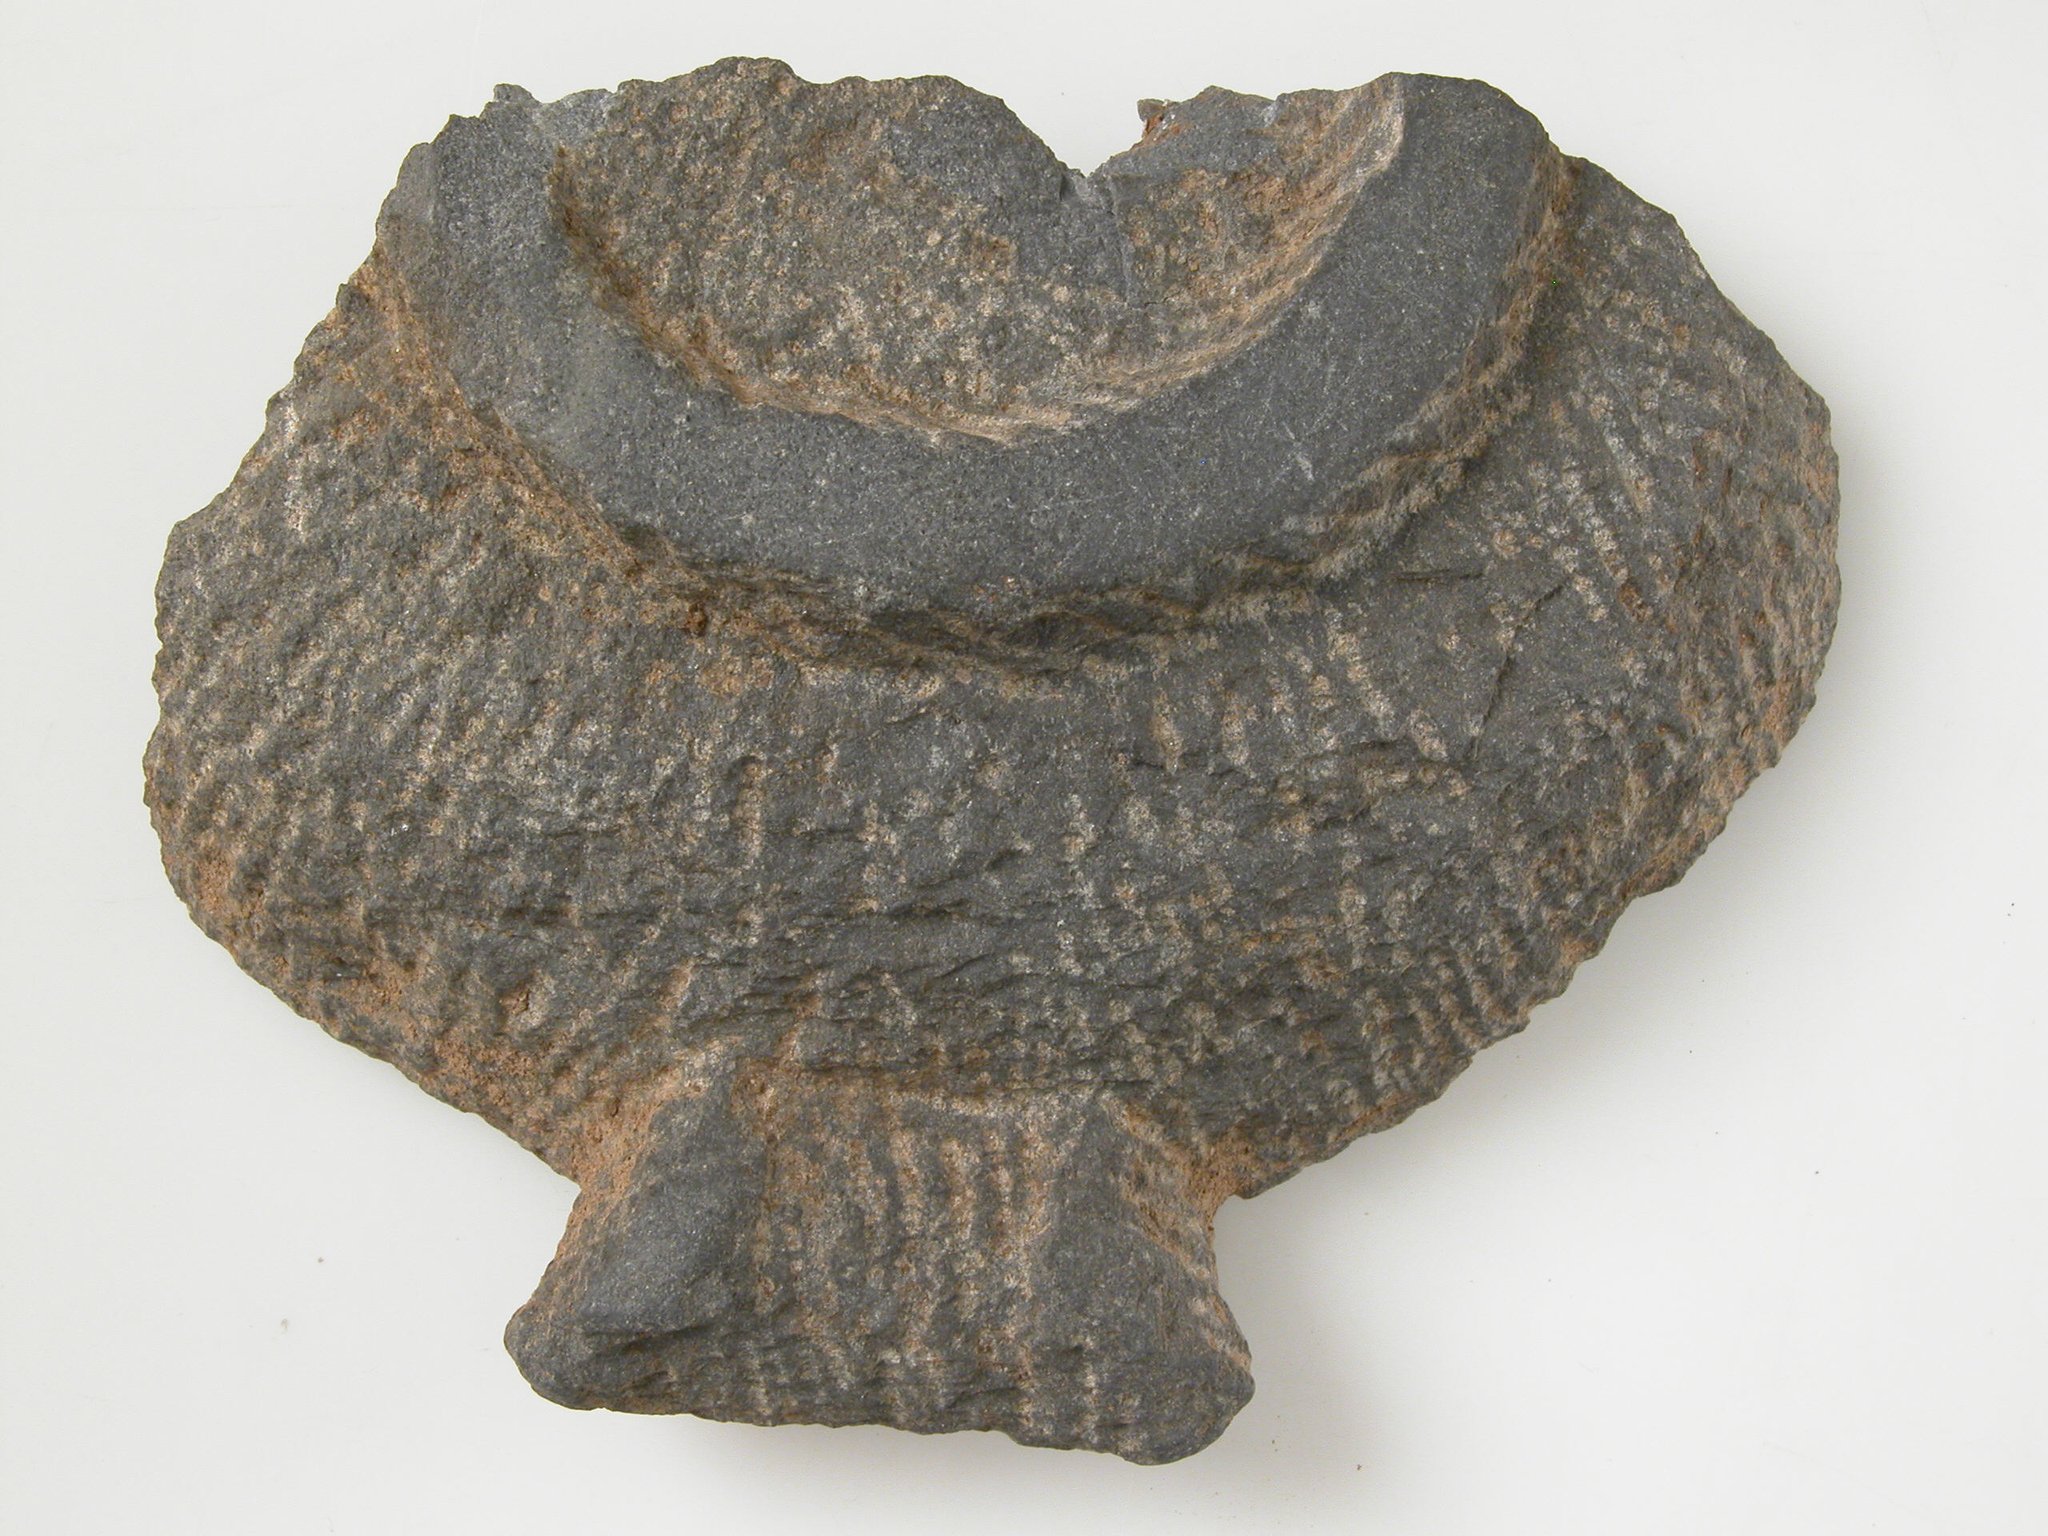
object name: bowl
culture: coptic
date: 301-700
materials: stone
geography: egypt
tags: bowls